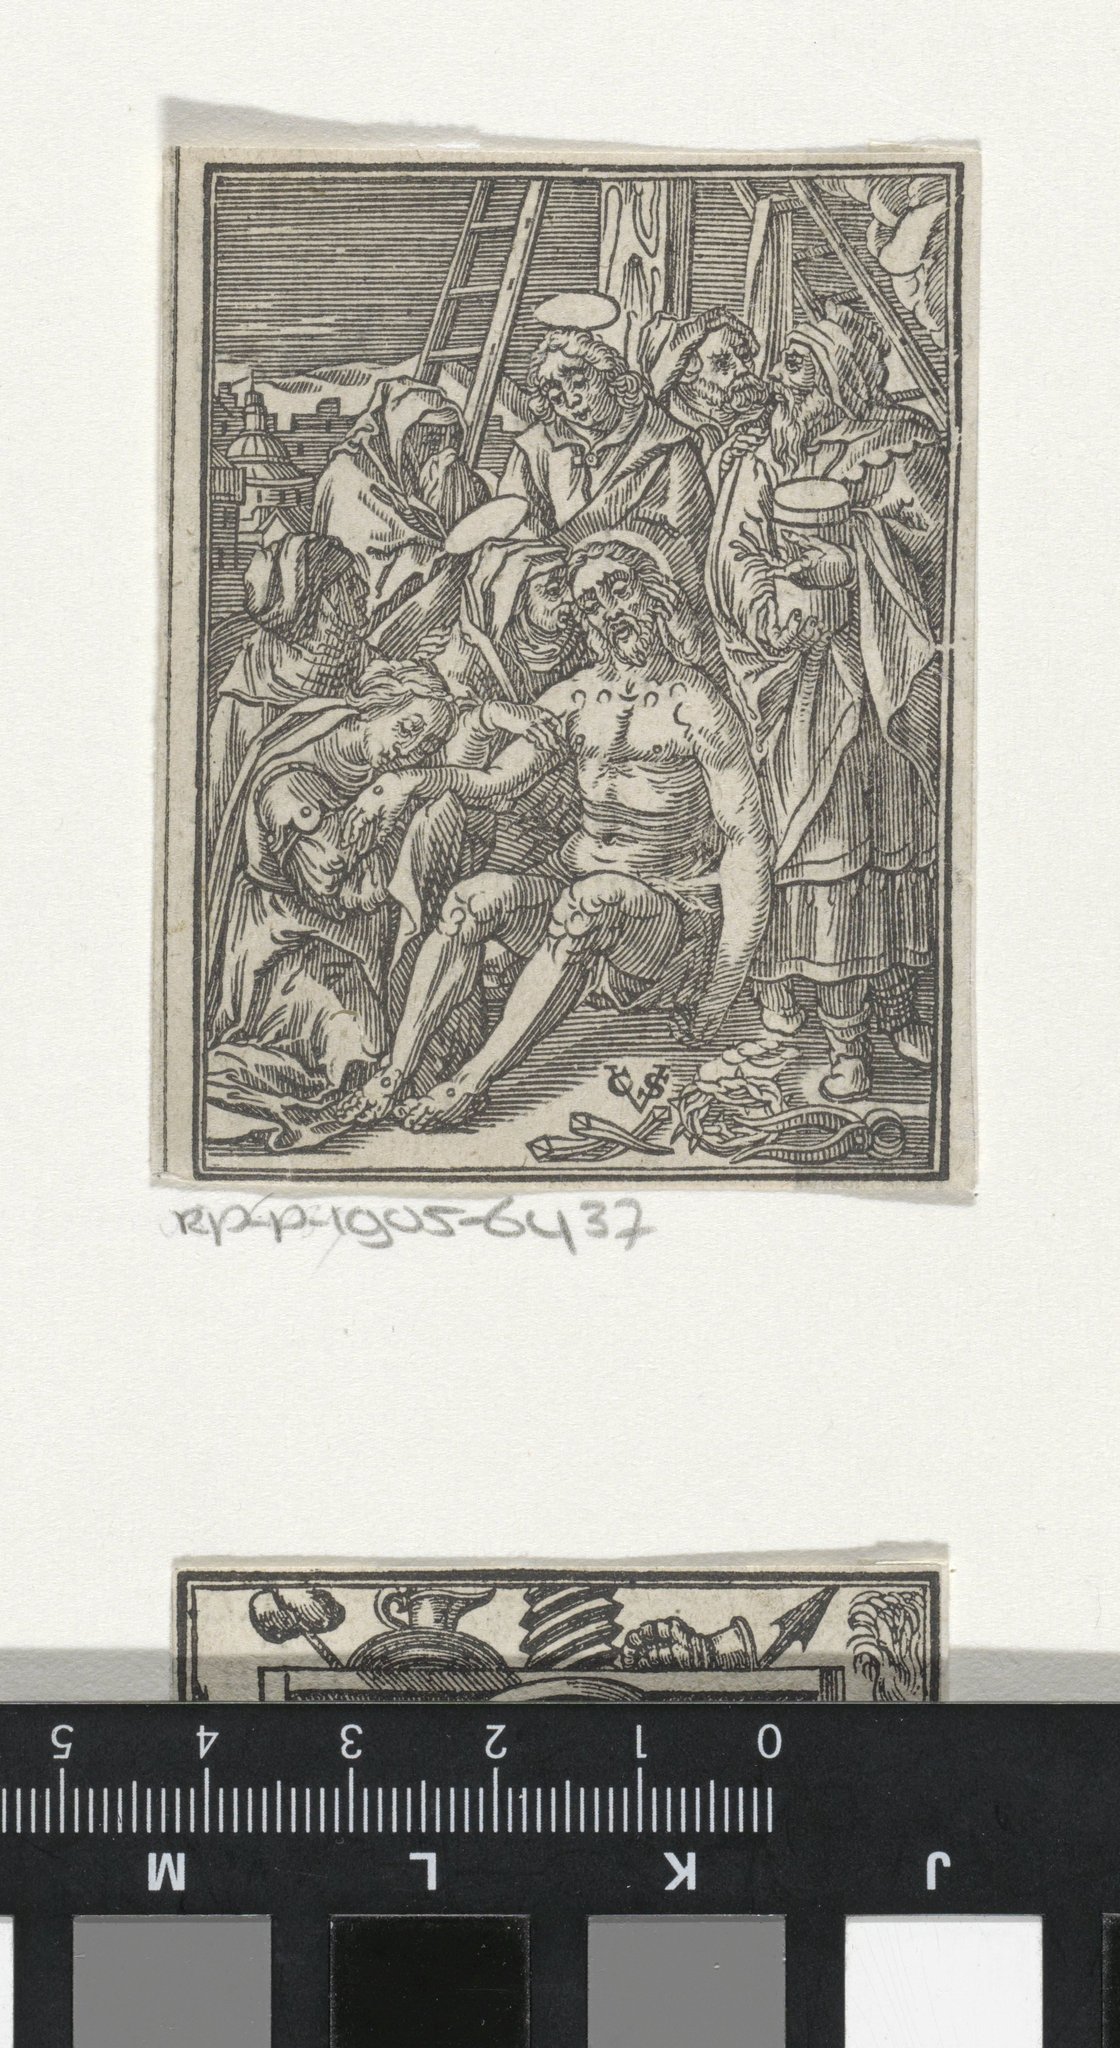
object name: book illustration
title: Bewening van Christus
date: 1648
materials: paper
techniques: letterpress printing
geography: amsterdam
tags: lamentation over the dead christ by his relatives and friends (christ usually without crown of thorns)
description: Prent uit: Sichem, Christoffel van (II). 'tSchat der zielen, dat is: Het geheele leven ons Heeren Iesu Christi. Amsterdam: Pieter Jacobsz. Paets, 1648. Prent uit: Biblia sacra dat is De geheele Heylighe Schrifture bedeylt in 't Out en Nieu Testament. Amsterdam: Pieter Jacobsz. Paets, 1657.